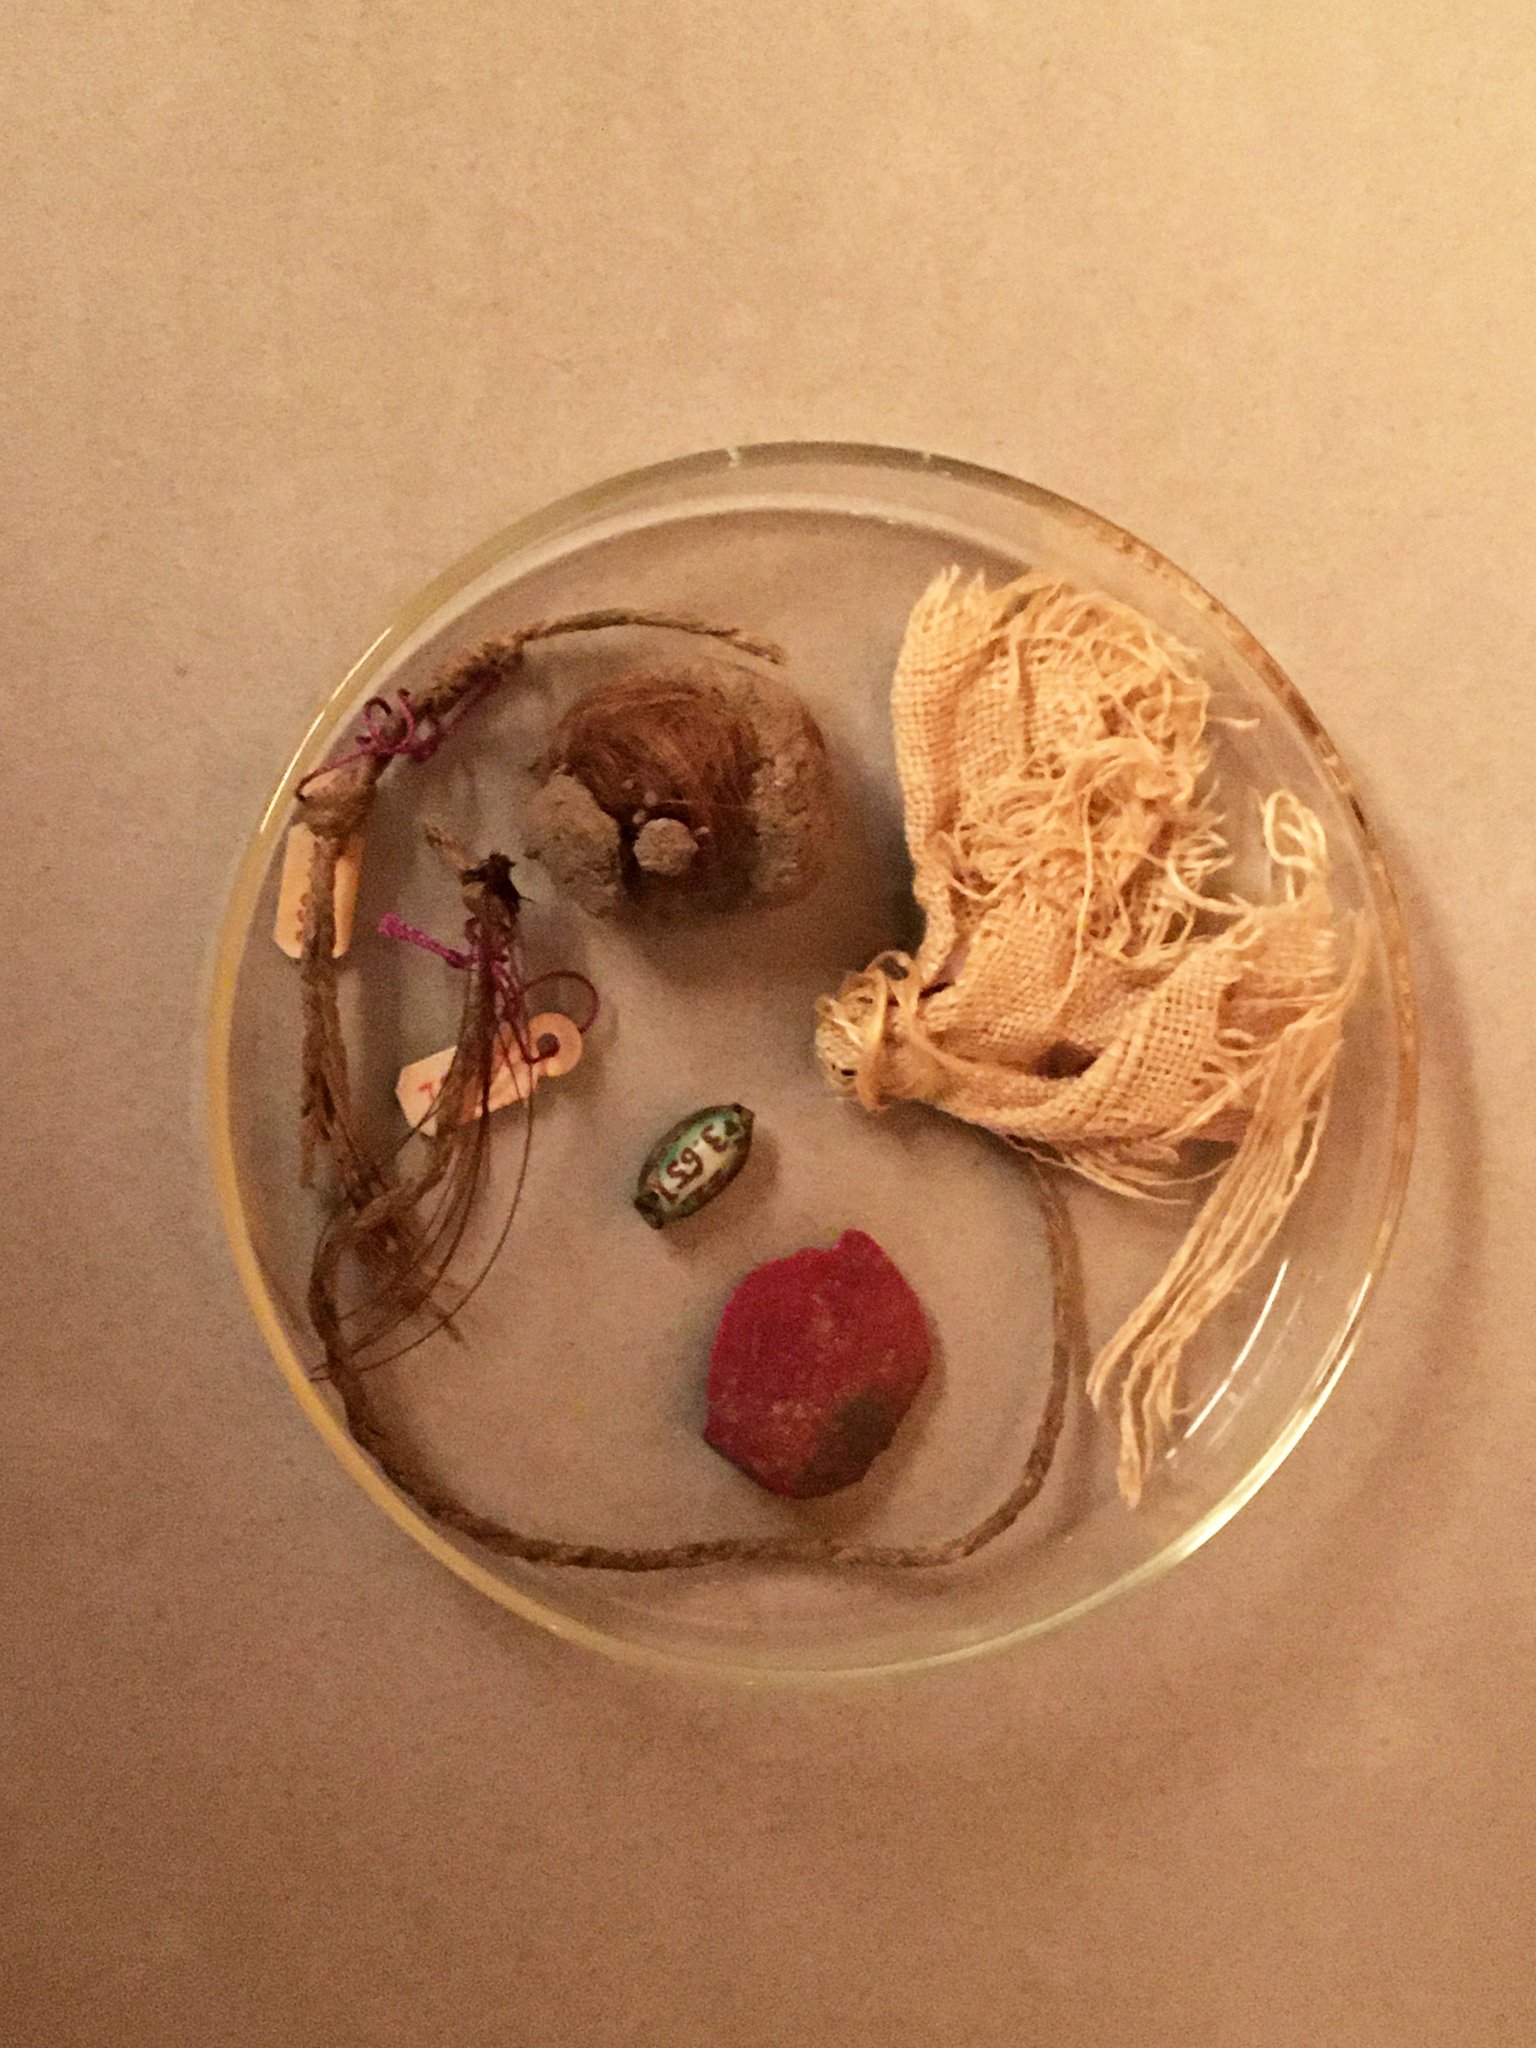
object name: scaraboid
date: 712-525 BCE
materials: gold, stone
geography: egypt